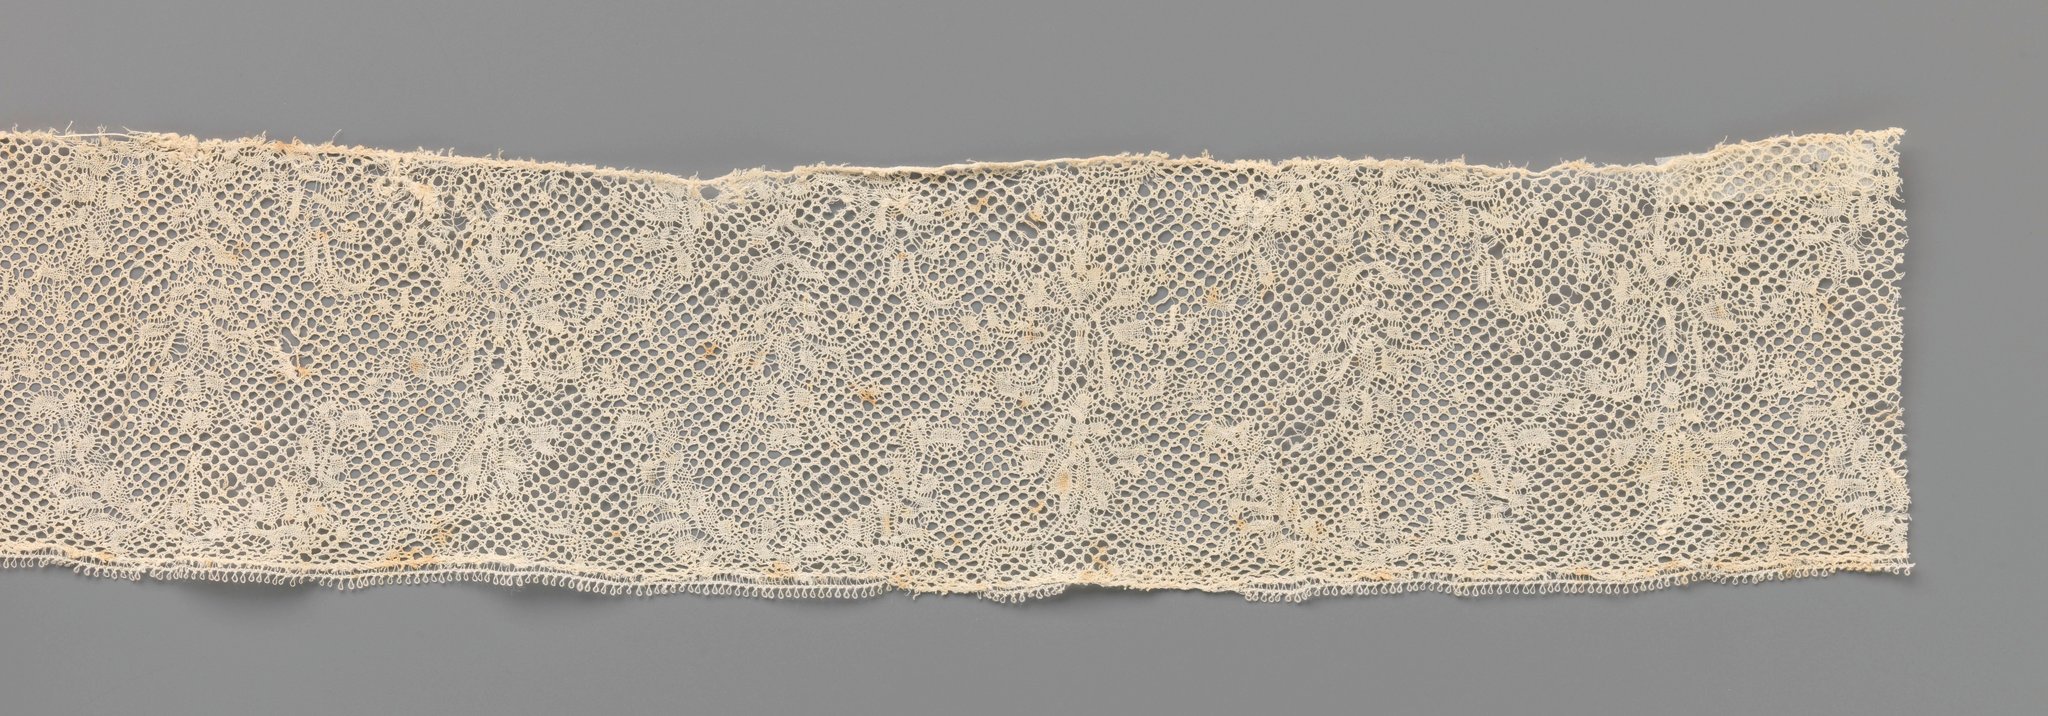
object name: strip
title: Strook kloskant met ruitvormige velden en kandelabermotieven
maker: Anonymous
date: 1690-1710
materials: linen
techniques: lace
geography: southern netherlands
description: Strook naturelkleurige kloskant, Binche-kant. Het zich herhalende en ijle patroon bestaat uit ruitvormige velden, gevormd door gevederde bladeren en op de middenlijn met elkaar verbonden door een symmetrisch kandelabermotief. Een smaller kandelabermotief staat ín het ruitvormige veld. De motieven zijn gemaakt in linnenslag met opengewerkte randjes en in netslag. Ze zijn met elkaar verbonden door een traliegrond, een vijfgaatjesgrond. Enkele sneeuwvlokken zijn gebruikt als onderdeel van de motieven. De boven- en onderzijde van de strook zijn recht afgewerkt, waarbij de onderzijde is voorzien van picots.